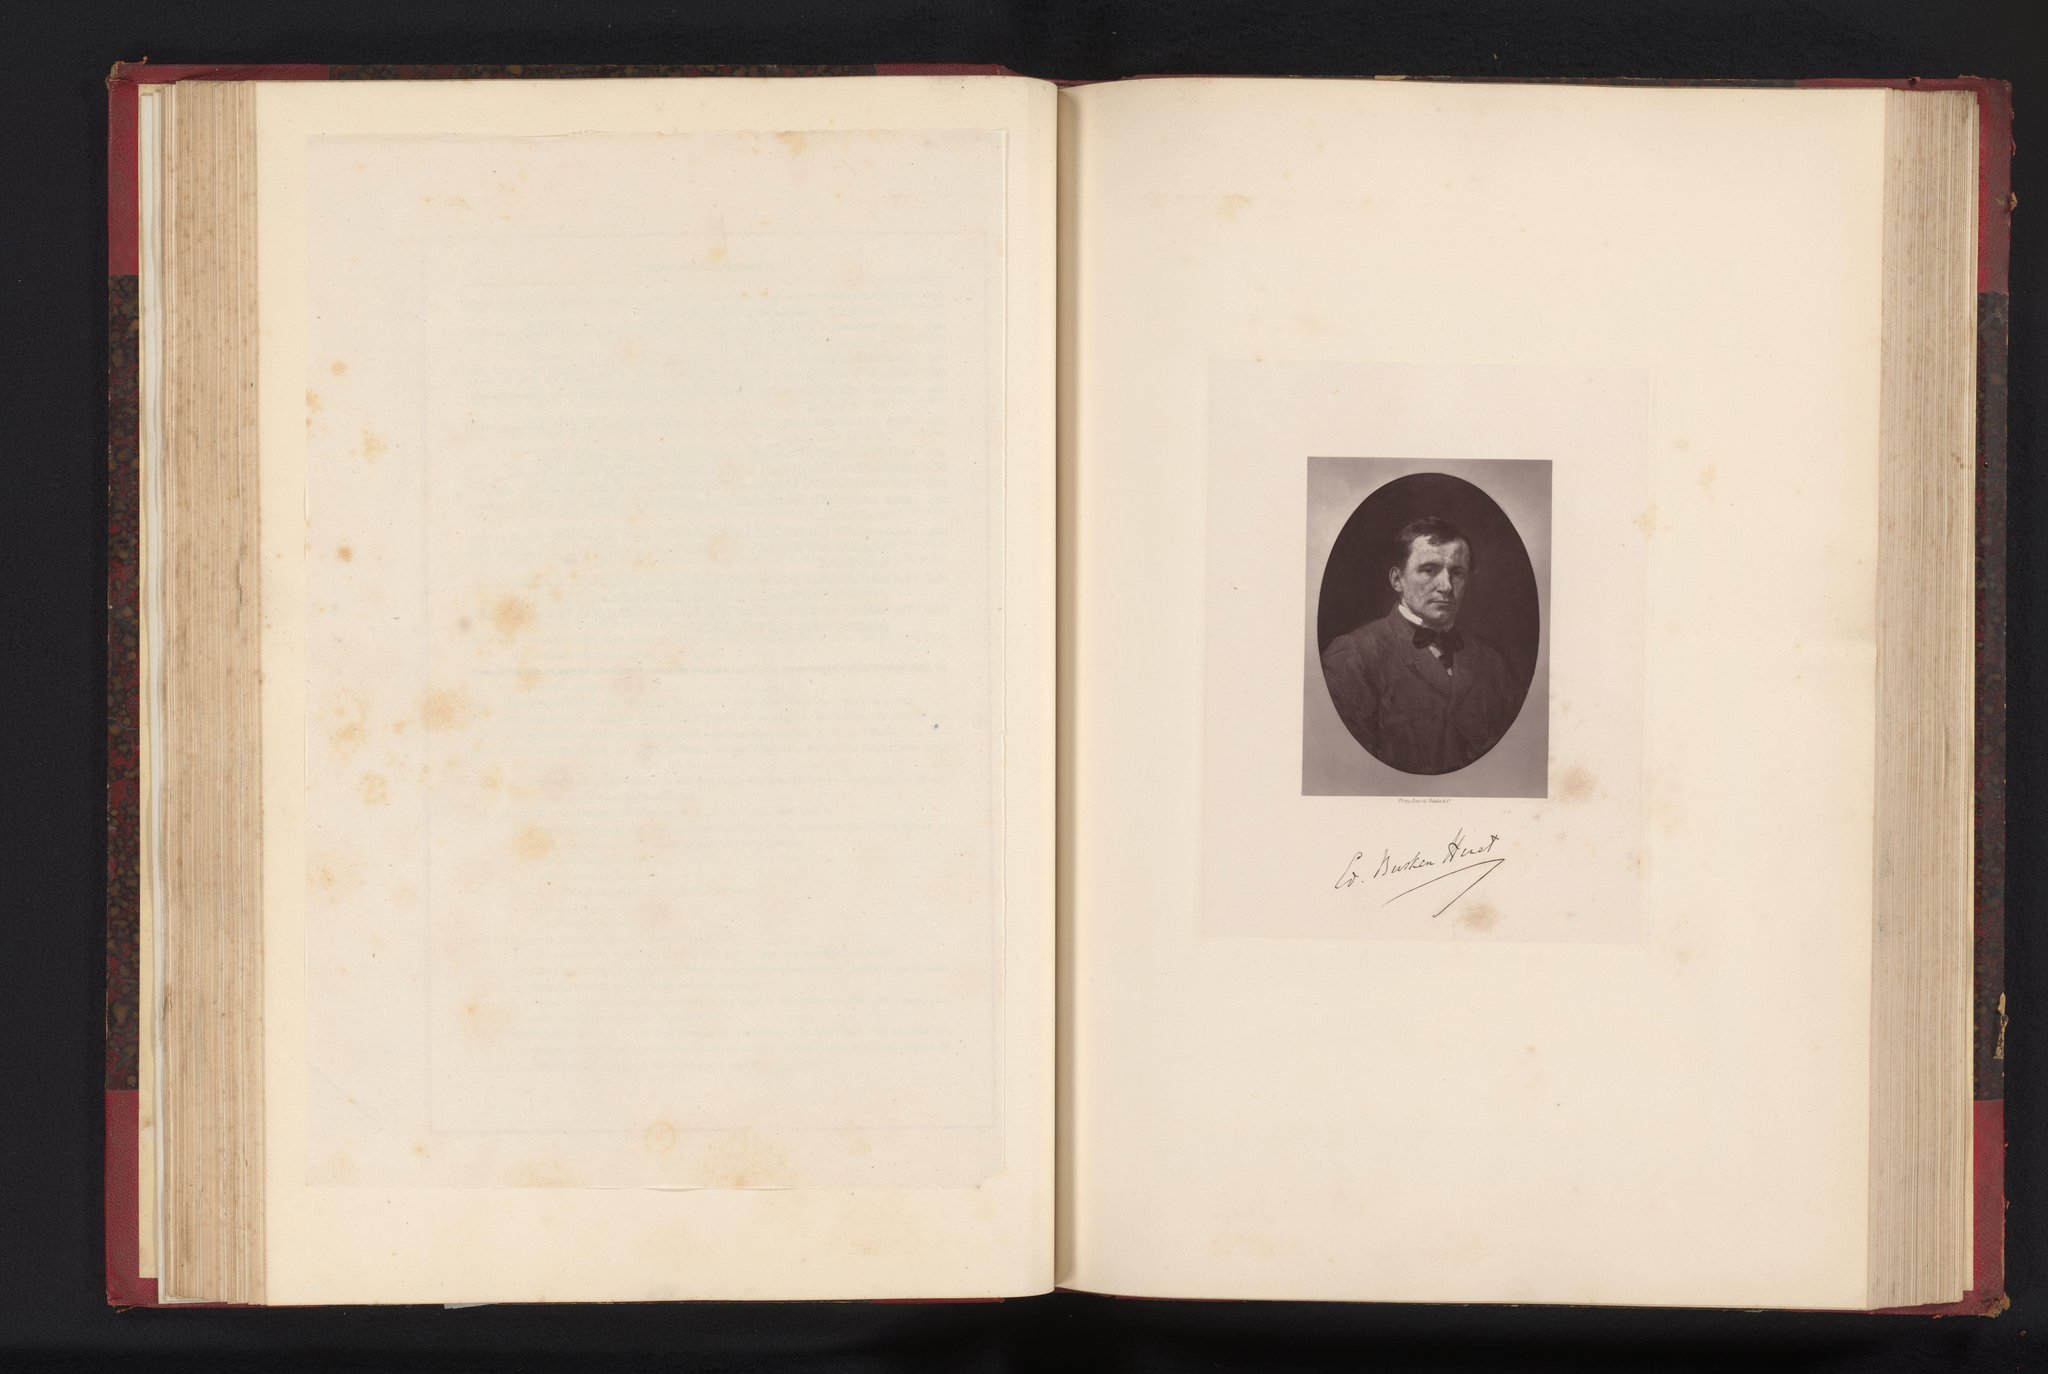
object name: page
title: Portret van Conrad Busken Huet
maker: Anonymous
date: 1878-1887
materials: paper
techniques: woodburytype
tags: paris, historical persons, writer, poet, author